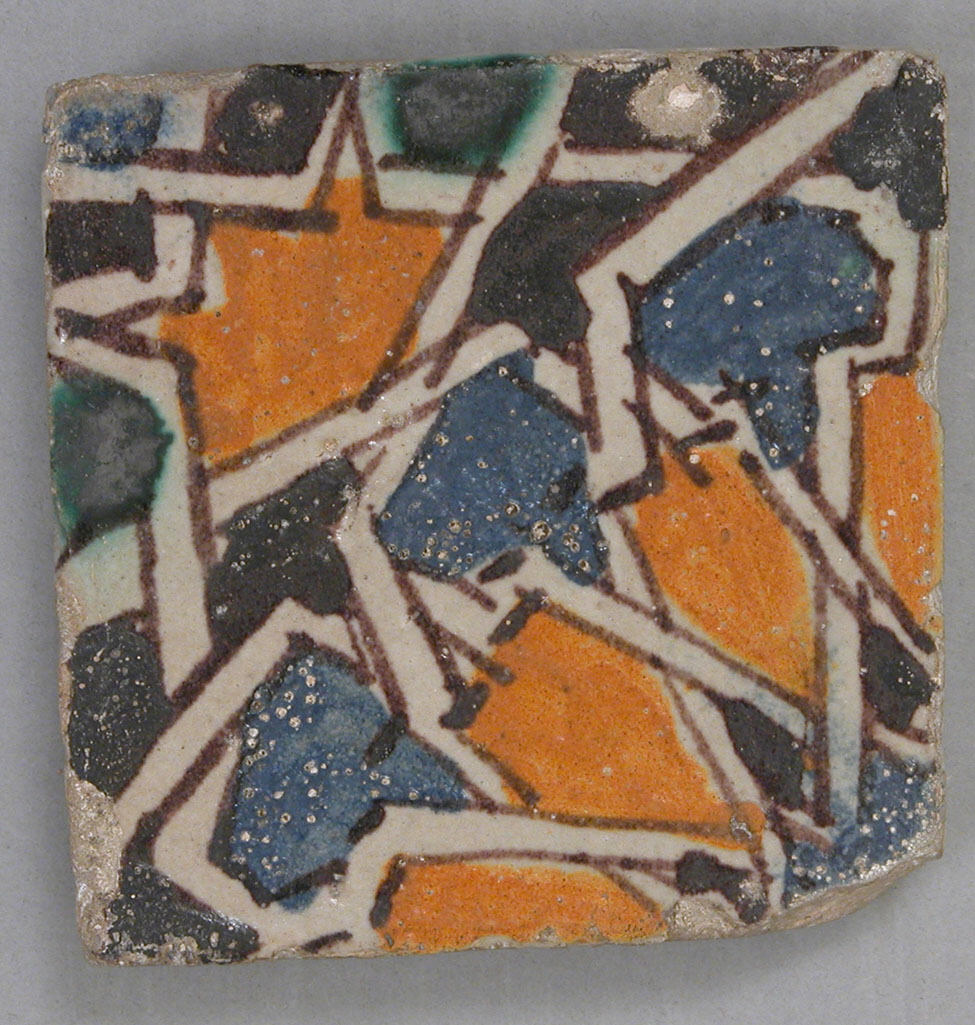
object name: tile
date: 1301-1500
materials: stonepaste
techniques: glazing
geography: tunisia